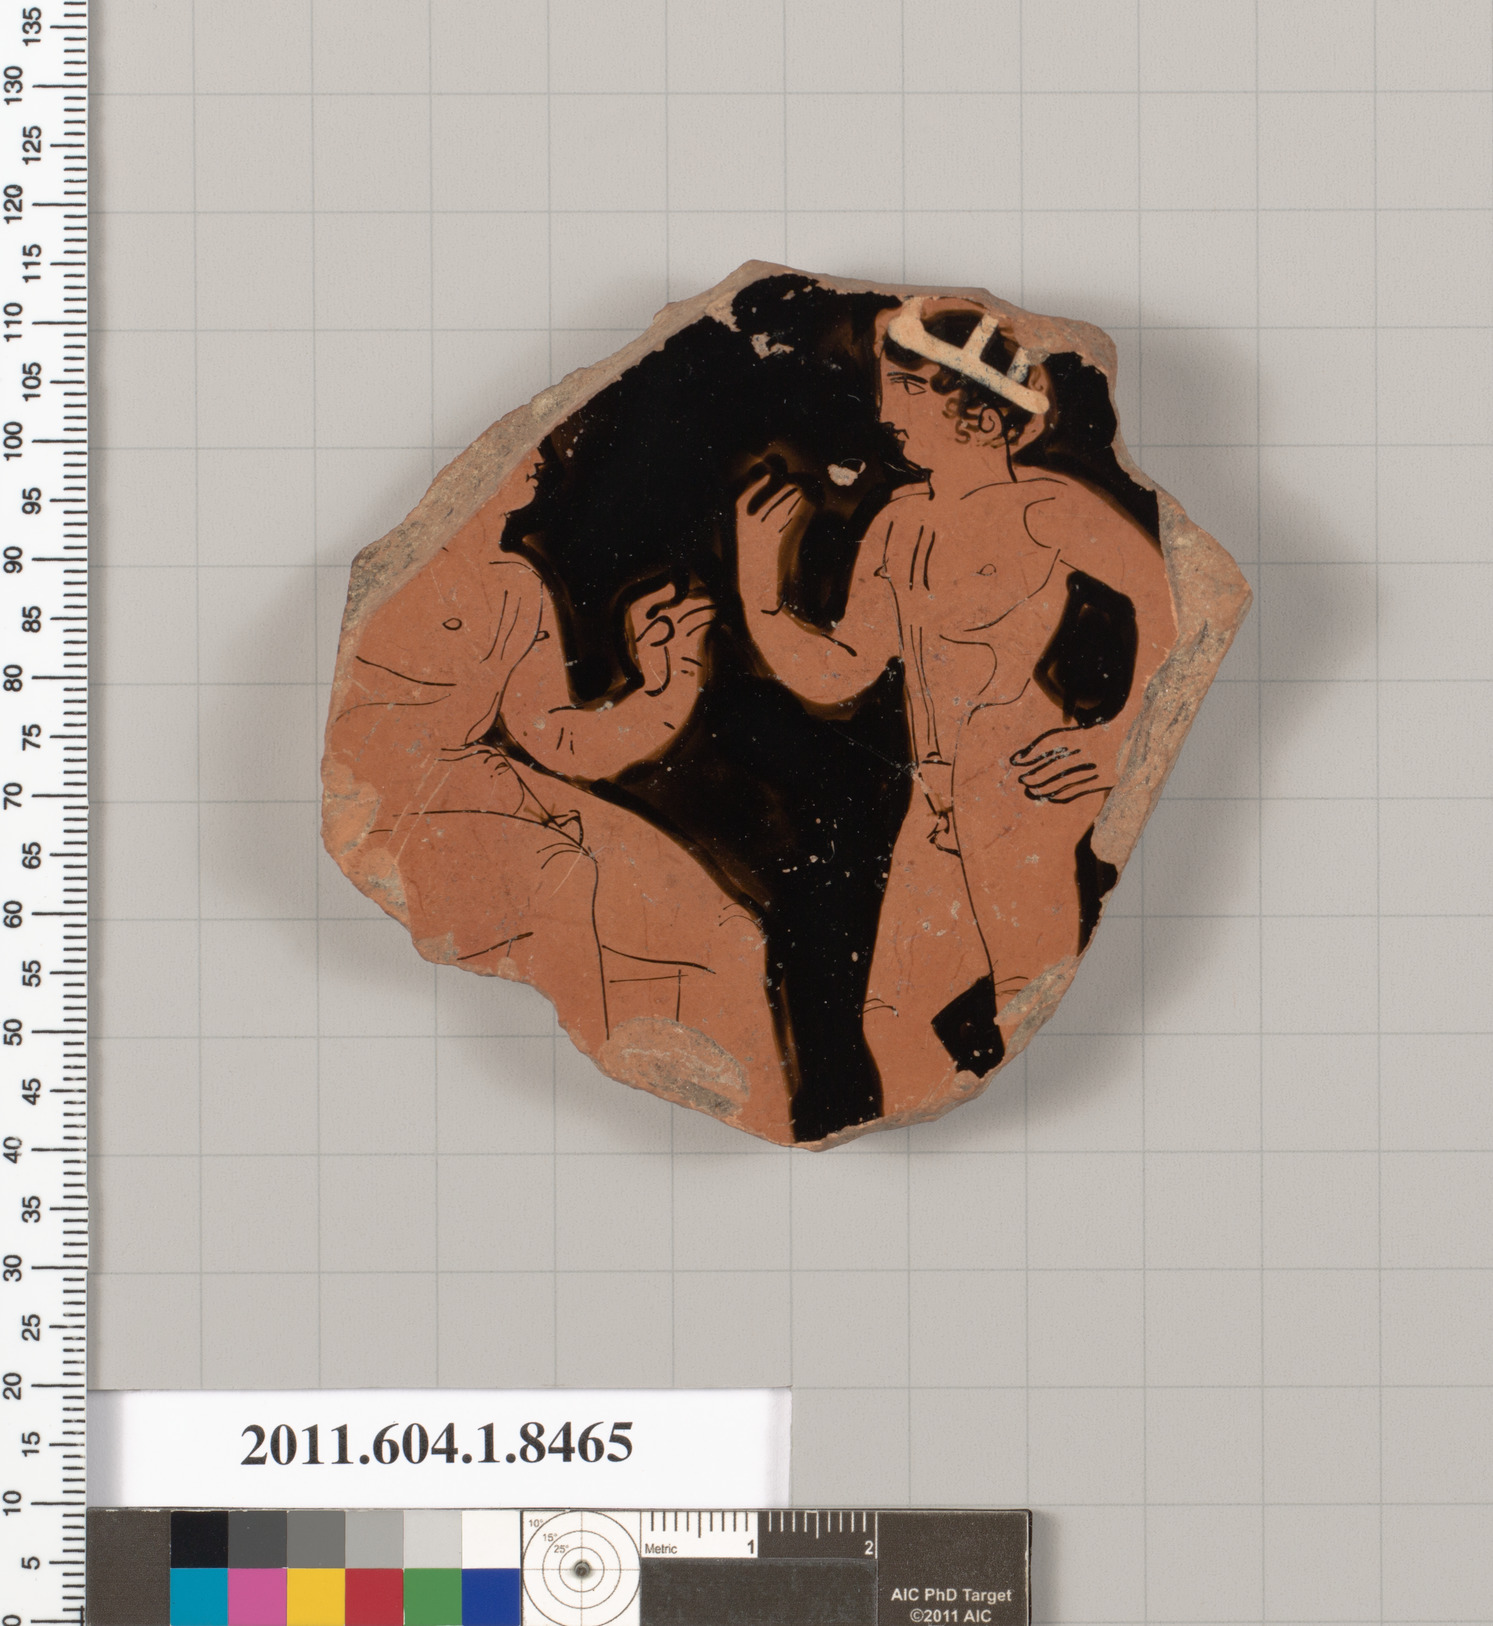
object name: kylix fragment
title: Terracotta fragment of a stemless kylix (drinking cup)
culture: greek, attic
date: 467-435 BCE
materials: terracotta